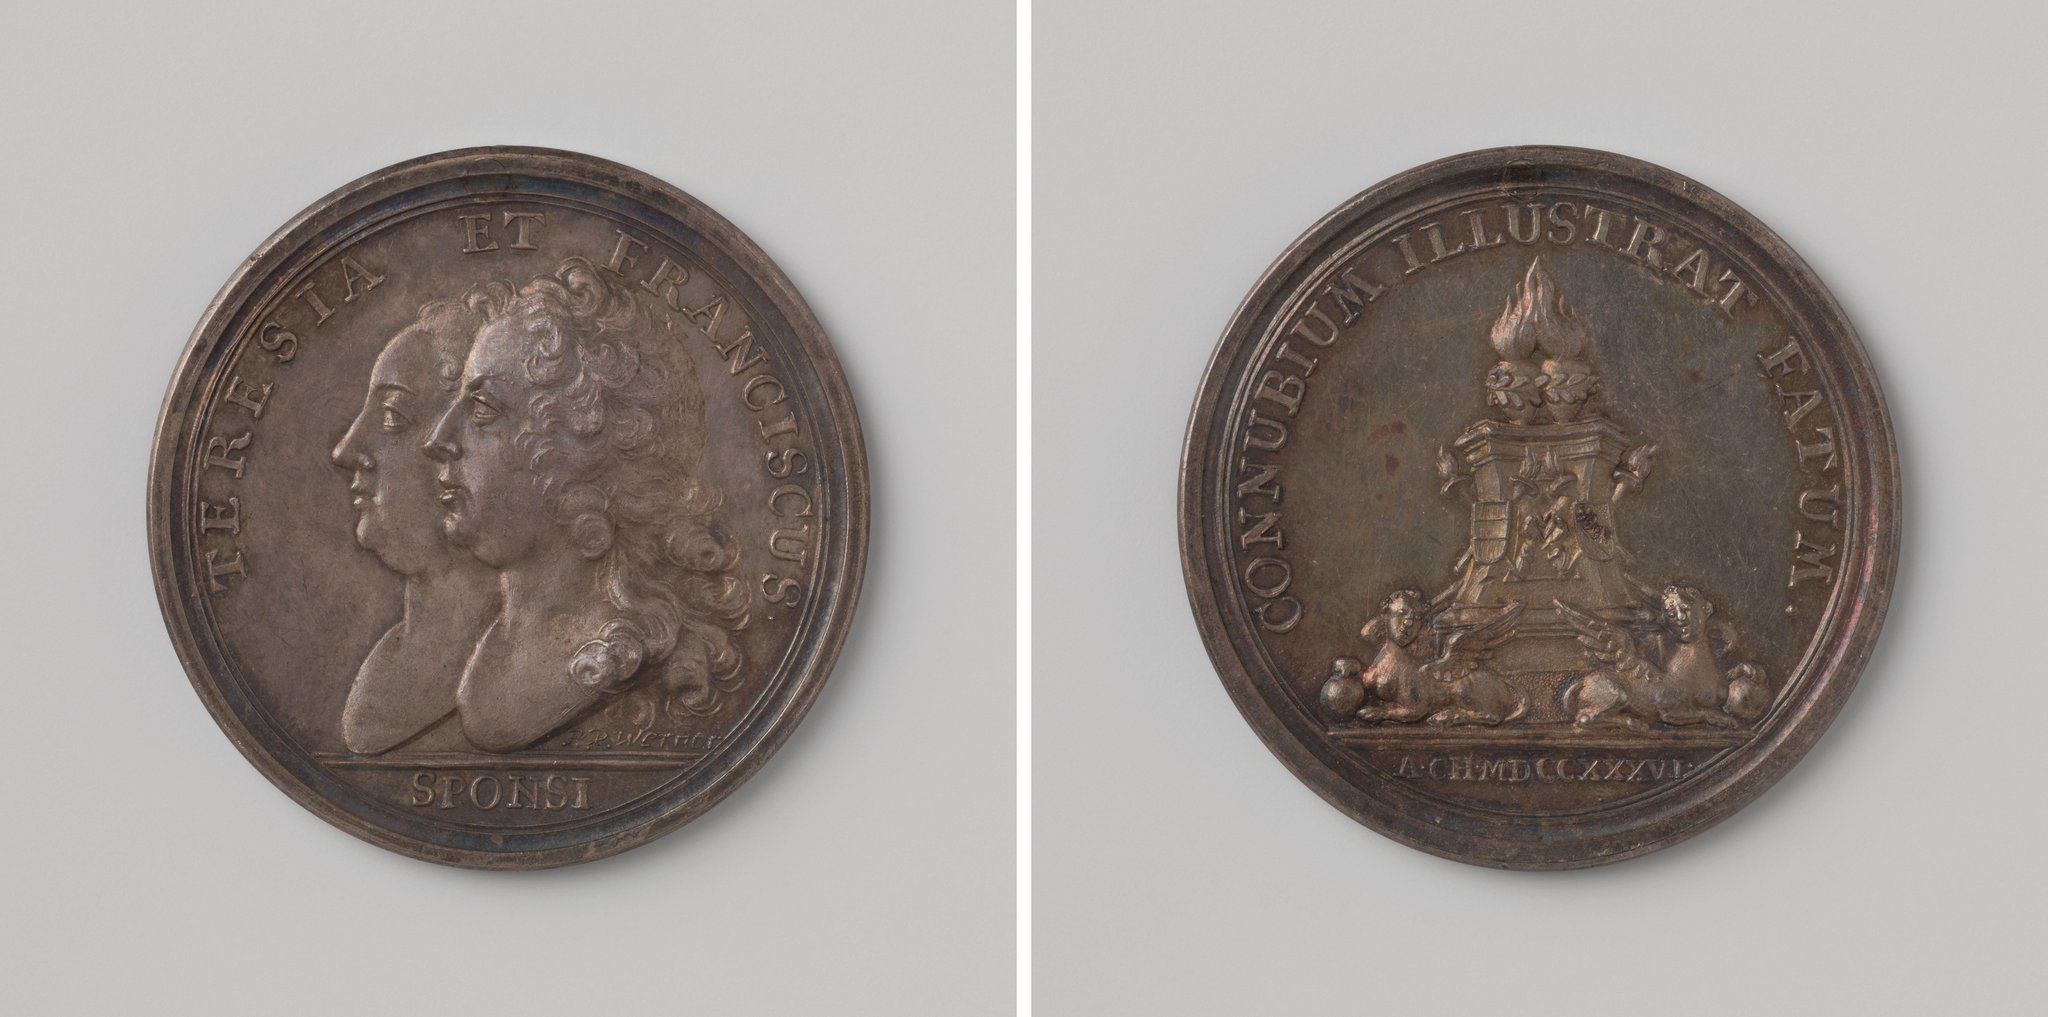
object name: history medal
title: Huwelijk van Frans Stephen, hertog van Lotharingen en Maria Theresia, aartshertogin van Oostenrijk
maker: peter paul werner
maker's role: medailleur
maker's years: 1689-1771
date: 1736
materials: silver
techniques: striking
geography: nuremberg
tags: vienna, maria theresia (rooms-duits keizerin), frans i stefan (duits keizer)